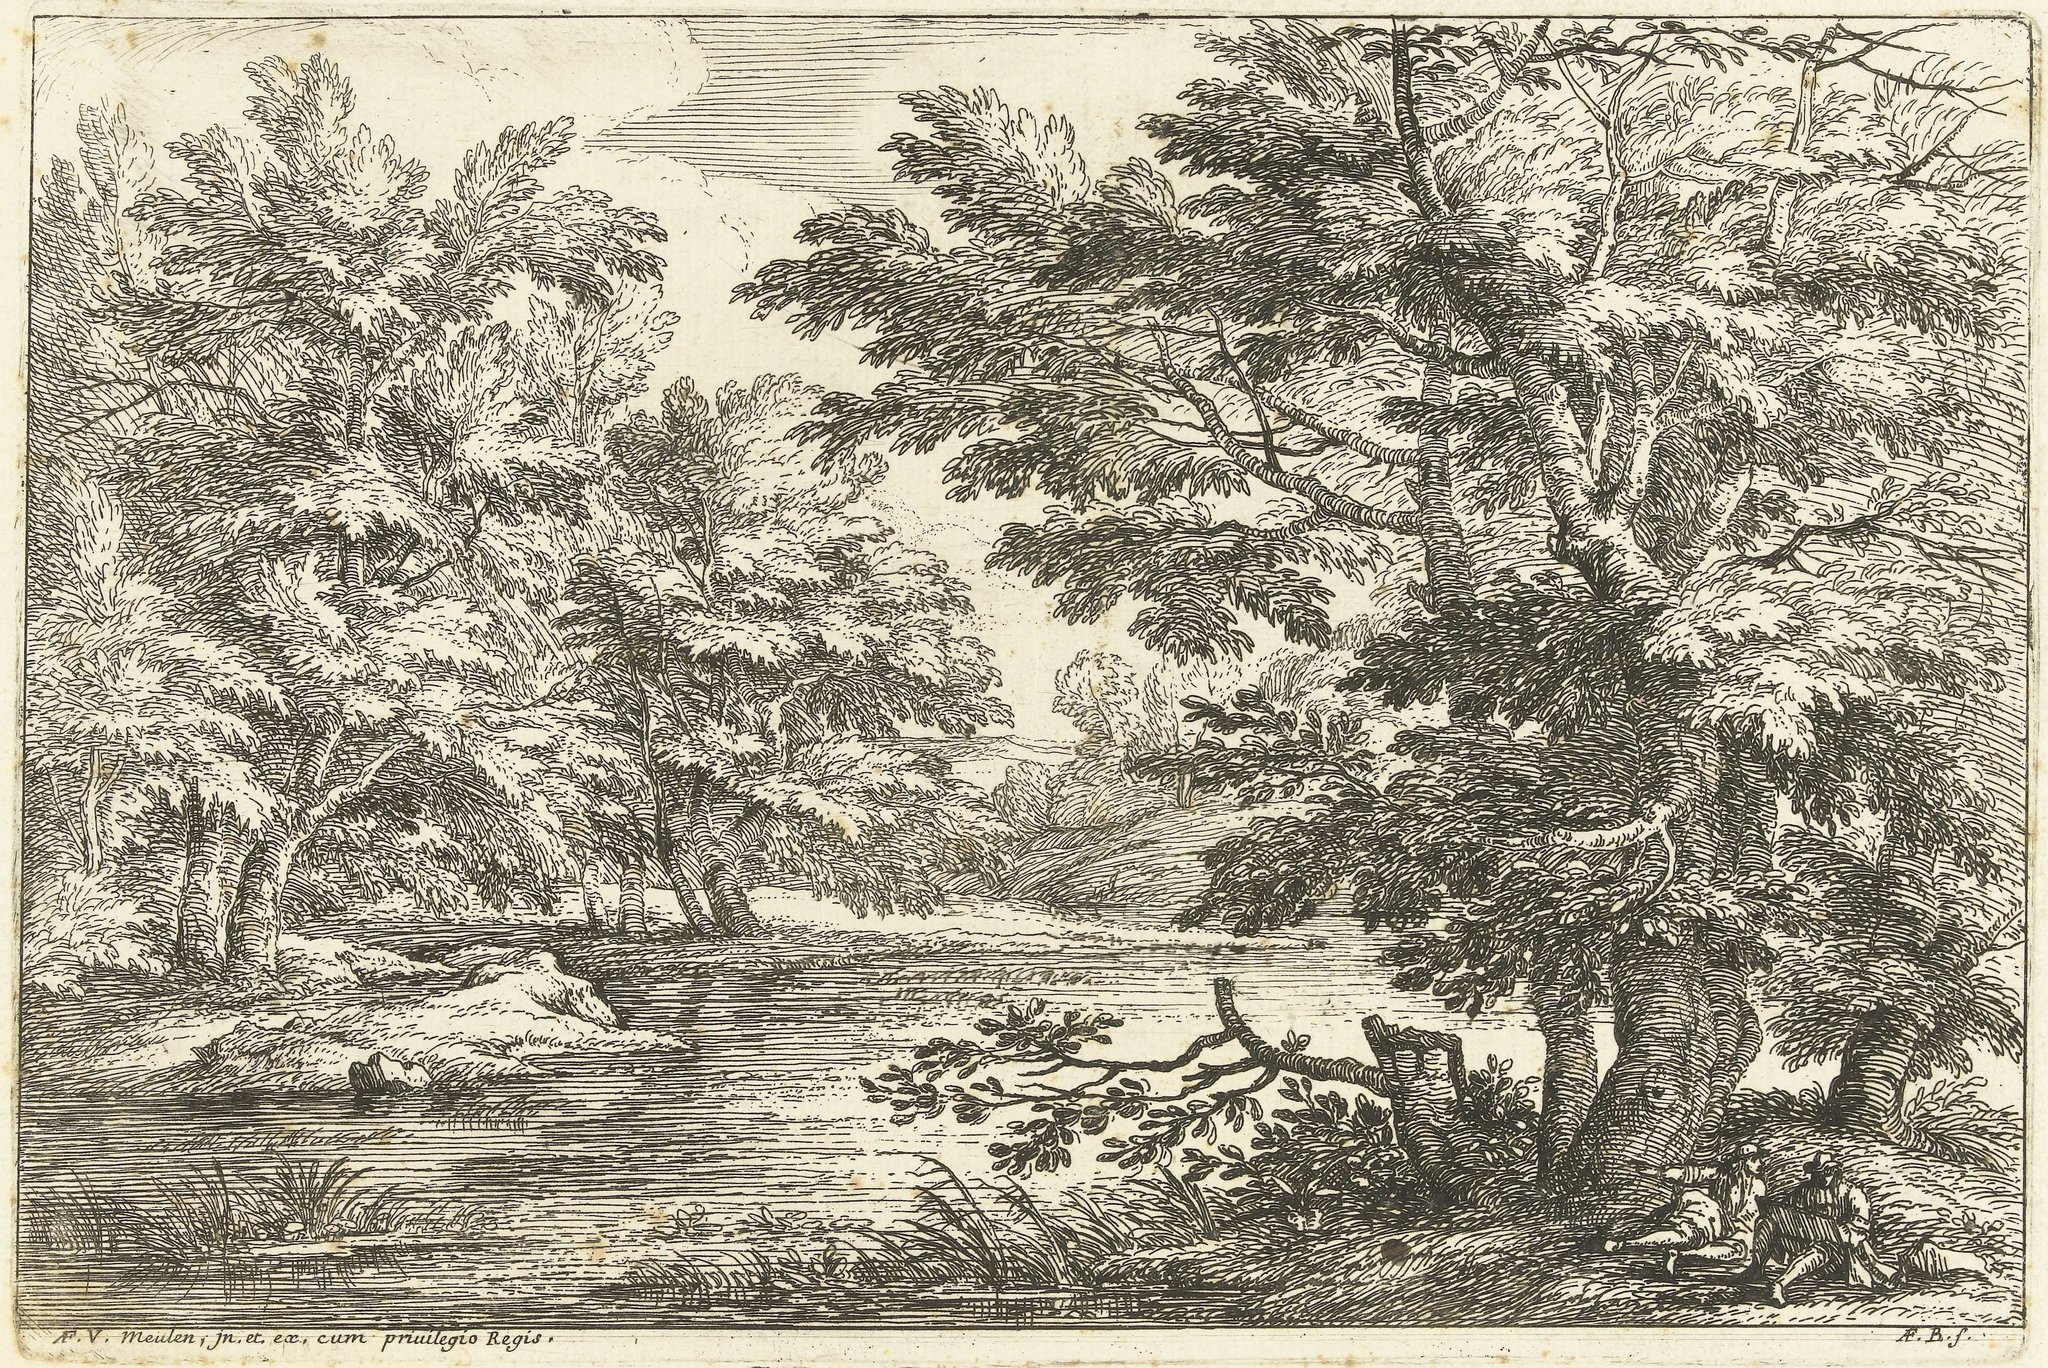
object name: print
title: Landschap met meertje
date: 1666-1681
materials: paper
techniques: etching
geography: paris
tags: lake, artist (in general) making preliminary designs, sketching - bb - out of doors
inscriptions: collector's mark: Lugt 240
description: Aan de oever van het meer zit een kunstenaar te tekenen. Naast hem zit een andere man die met zijn hand naar iets wijst.